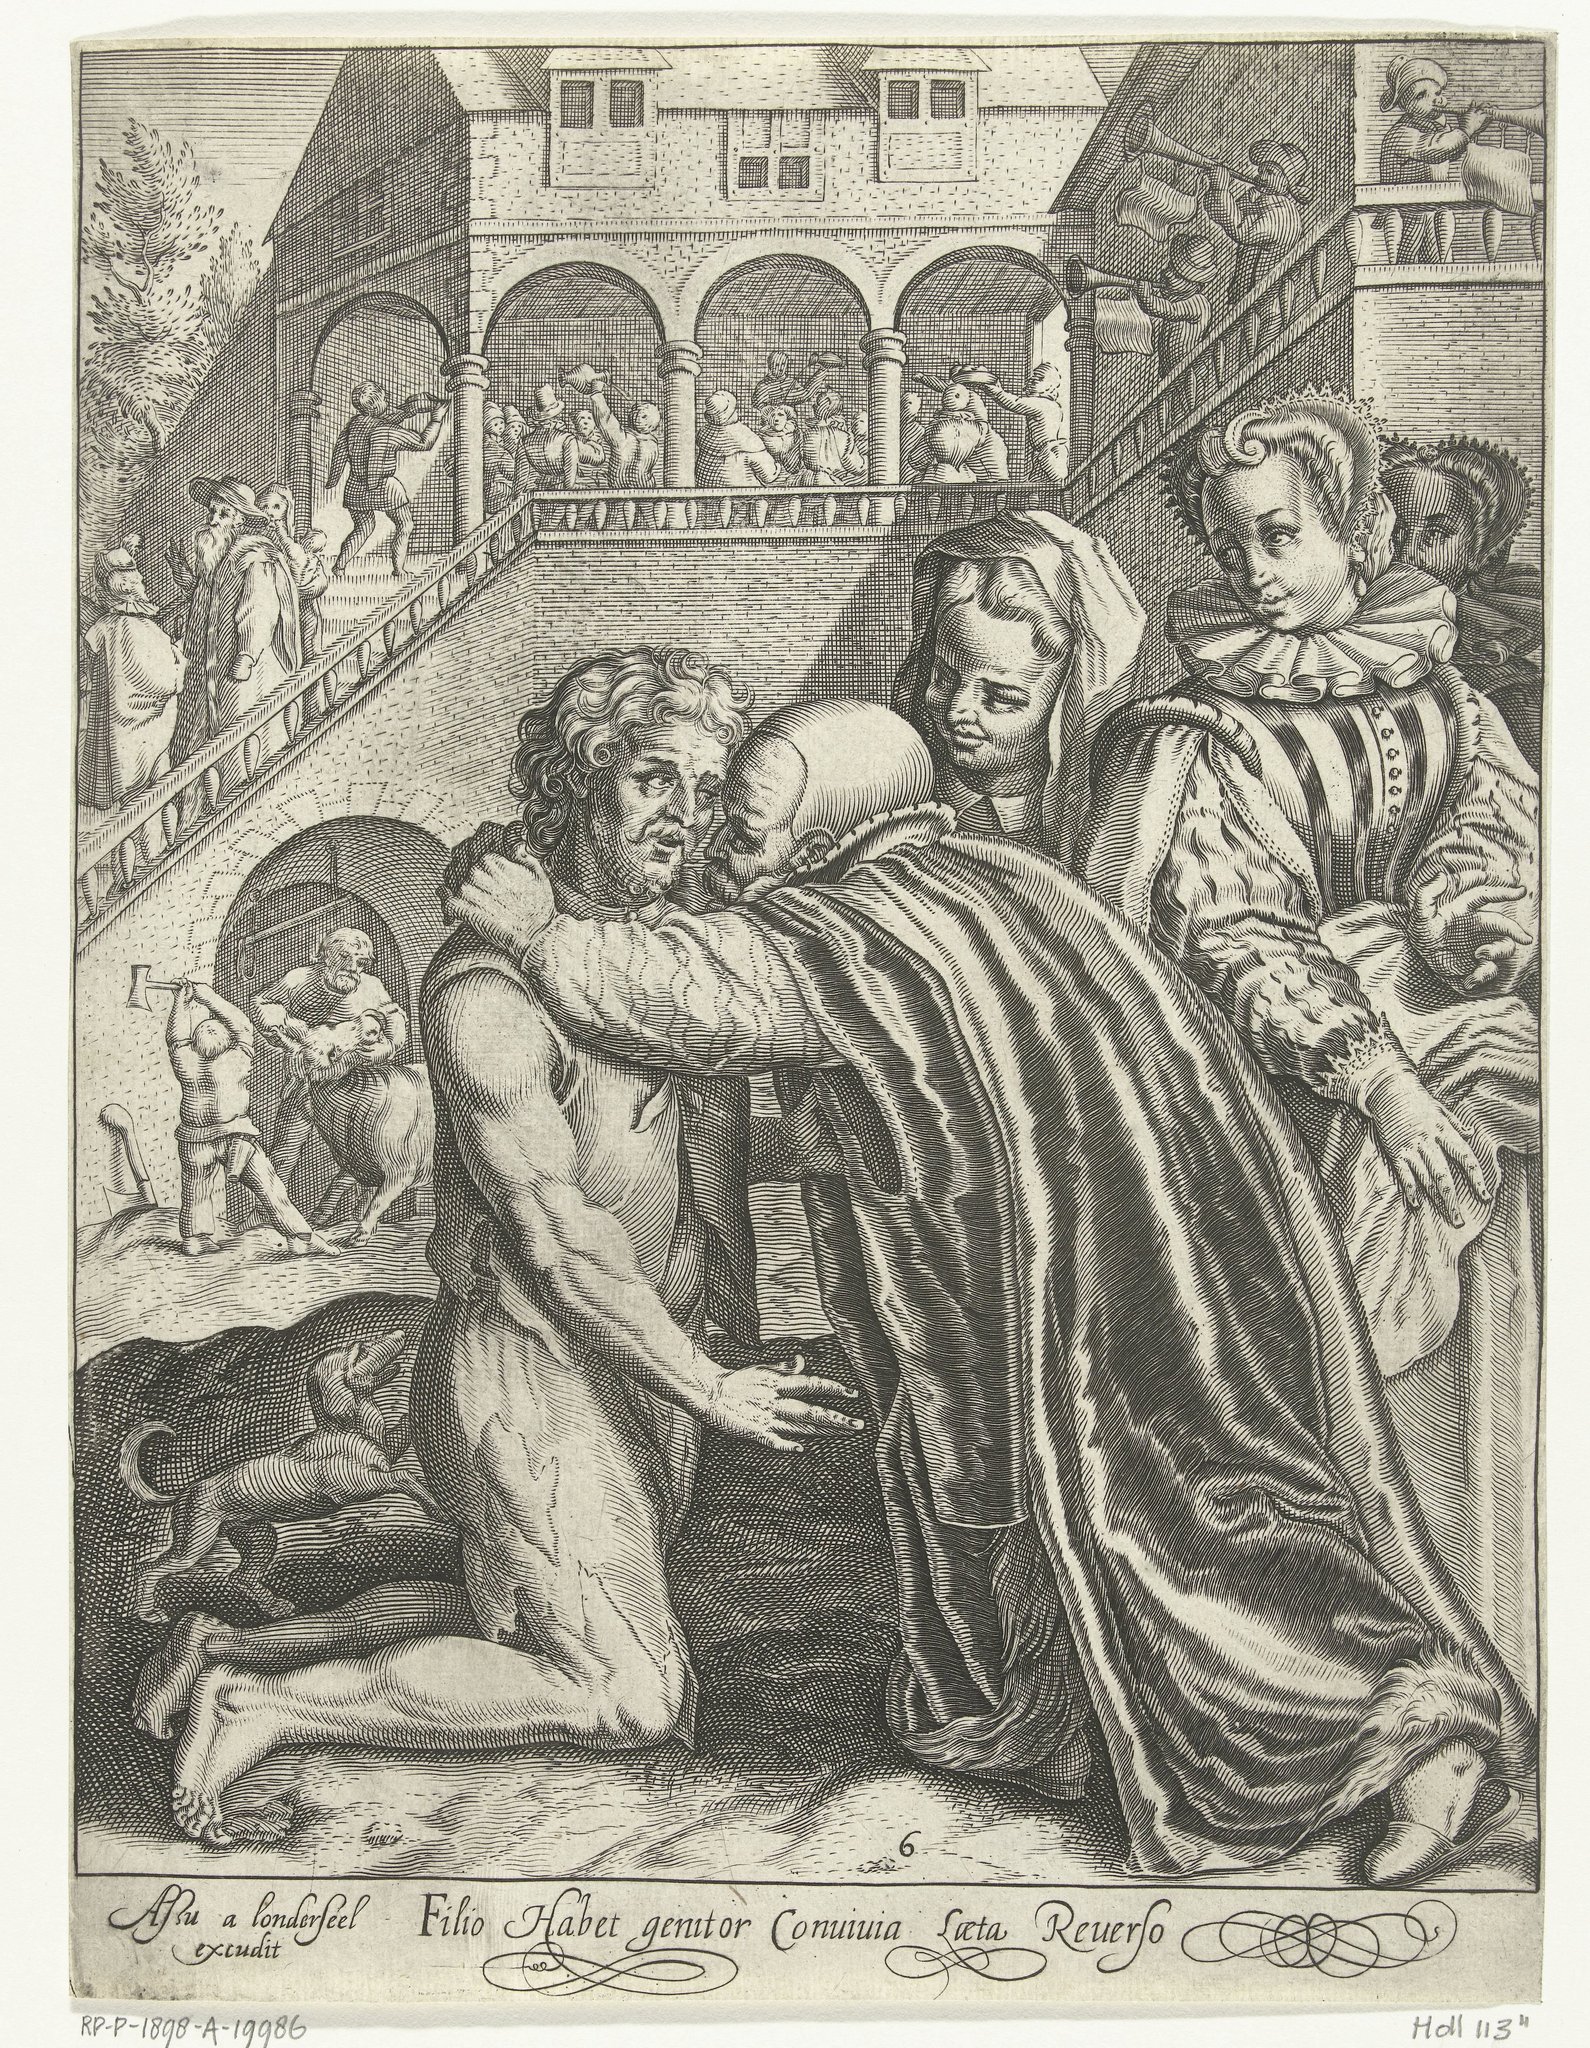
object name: print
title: Verhaal van de verloren zoon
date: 1581-1656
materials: paper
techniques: engraving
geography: netherlands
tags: the prodigal son returns home, where his father awaits him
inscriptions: collector's mark: Lugt 2228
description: De verloren zoon knielt in lompen gekleed voor zijn vader die hem omarmt.